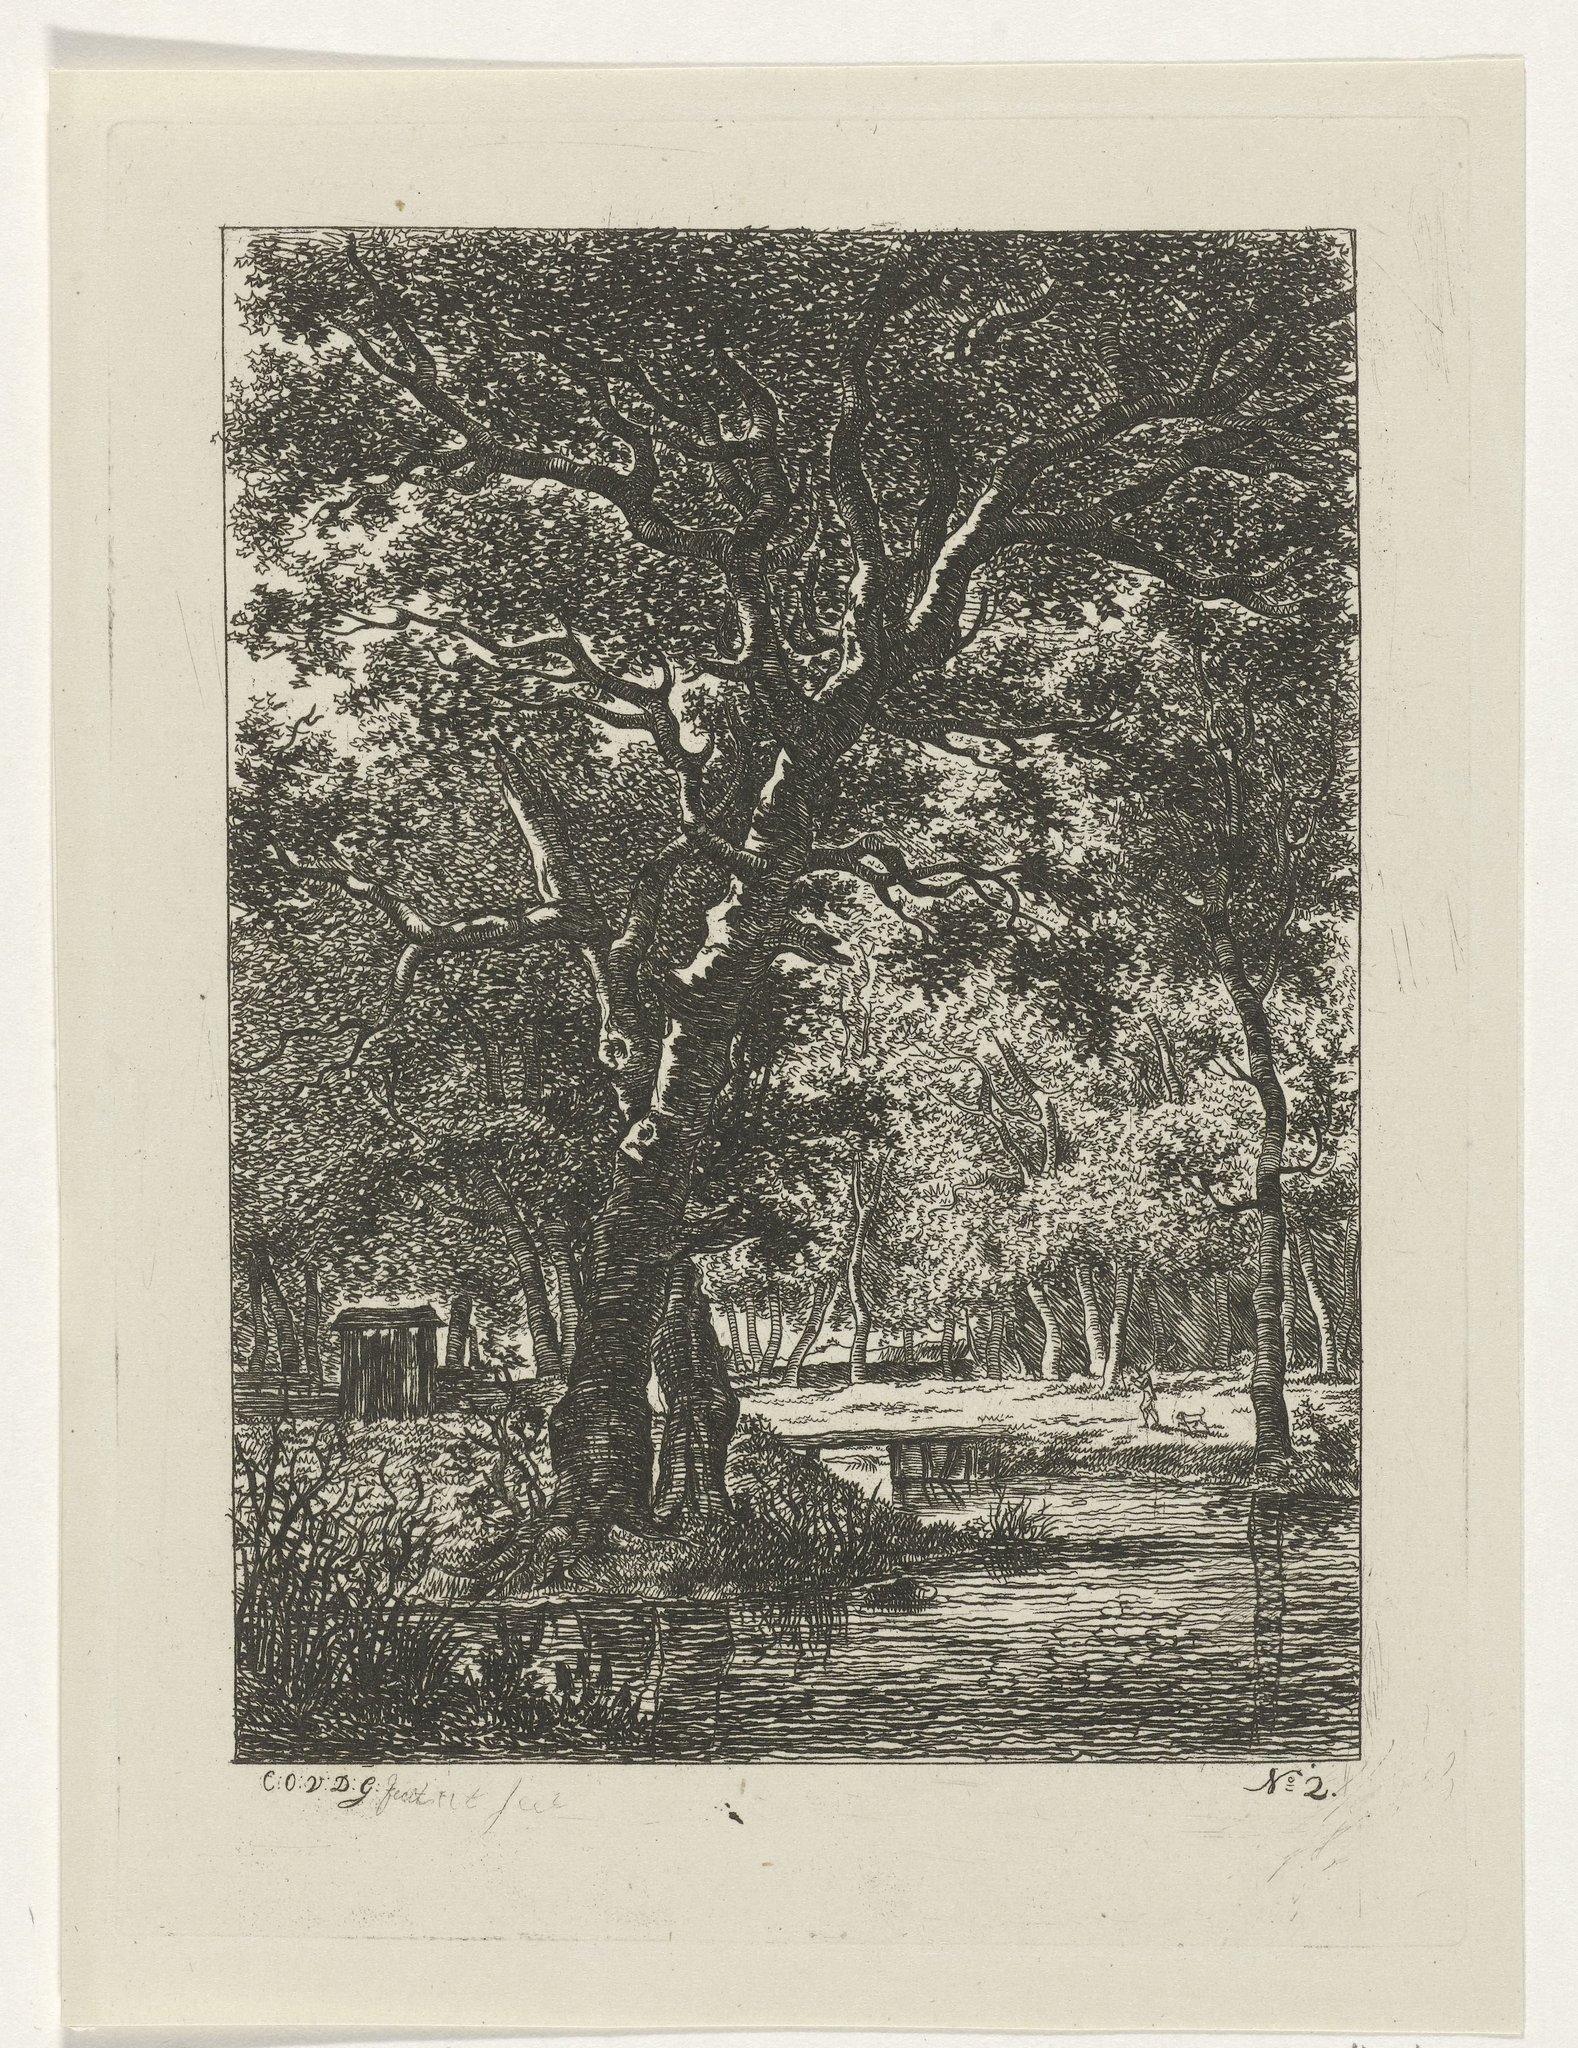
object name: print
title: Bosgezicht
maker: cornelis ouboter van der griendt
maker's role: print maker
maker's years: 1797-1868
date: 1807-1868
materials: paper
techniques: etching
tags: river, forest, wood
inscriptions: collector's mark: Lugt 2760, collector's mark: Lugt 2228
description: Bosgezicht met een riviertje en links een hut.